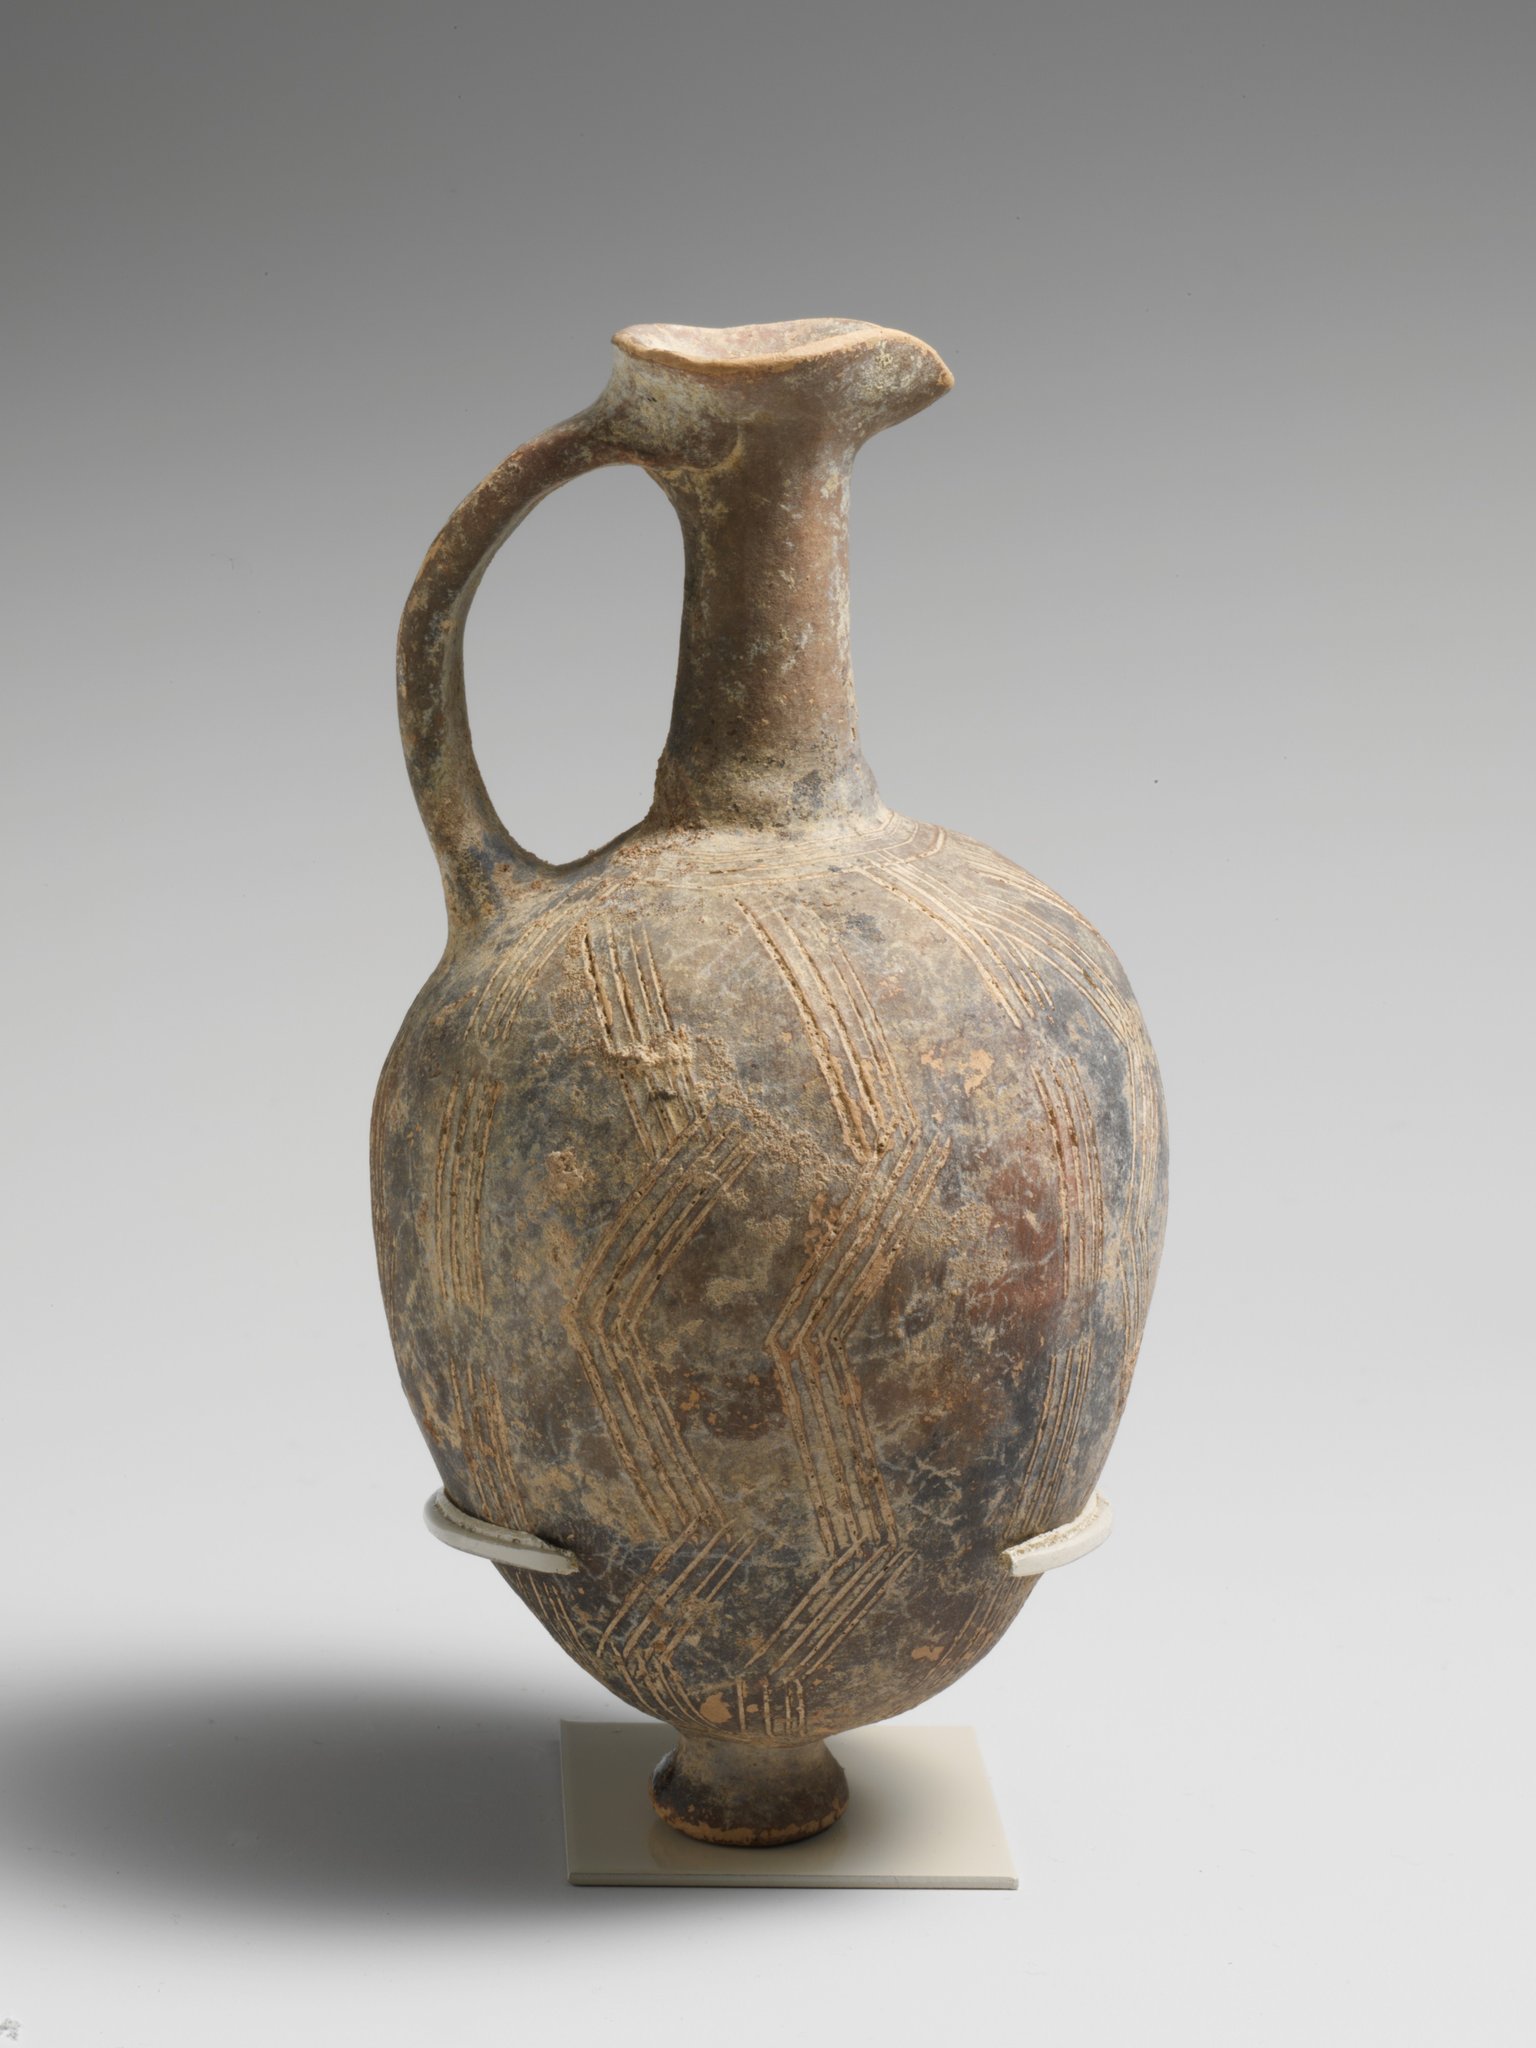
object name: jug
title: Terracotta jug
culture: cypriot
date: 1725-1600 BCE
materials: terracotta